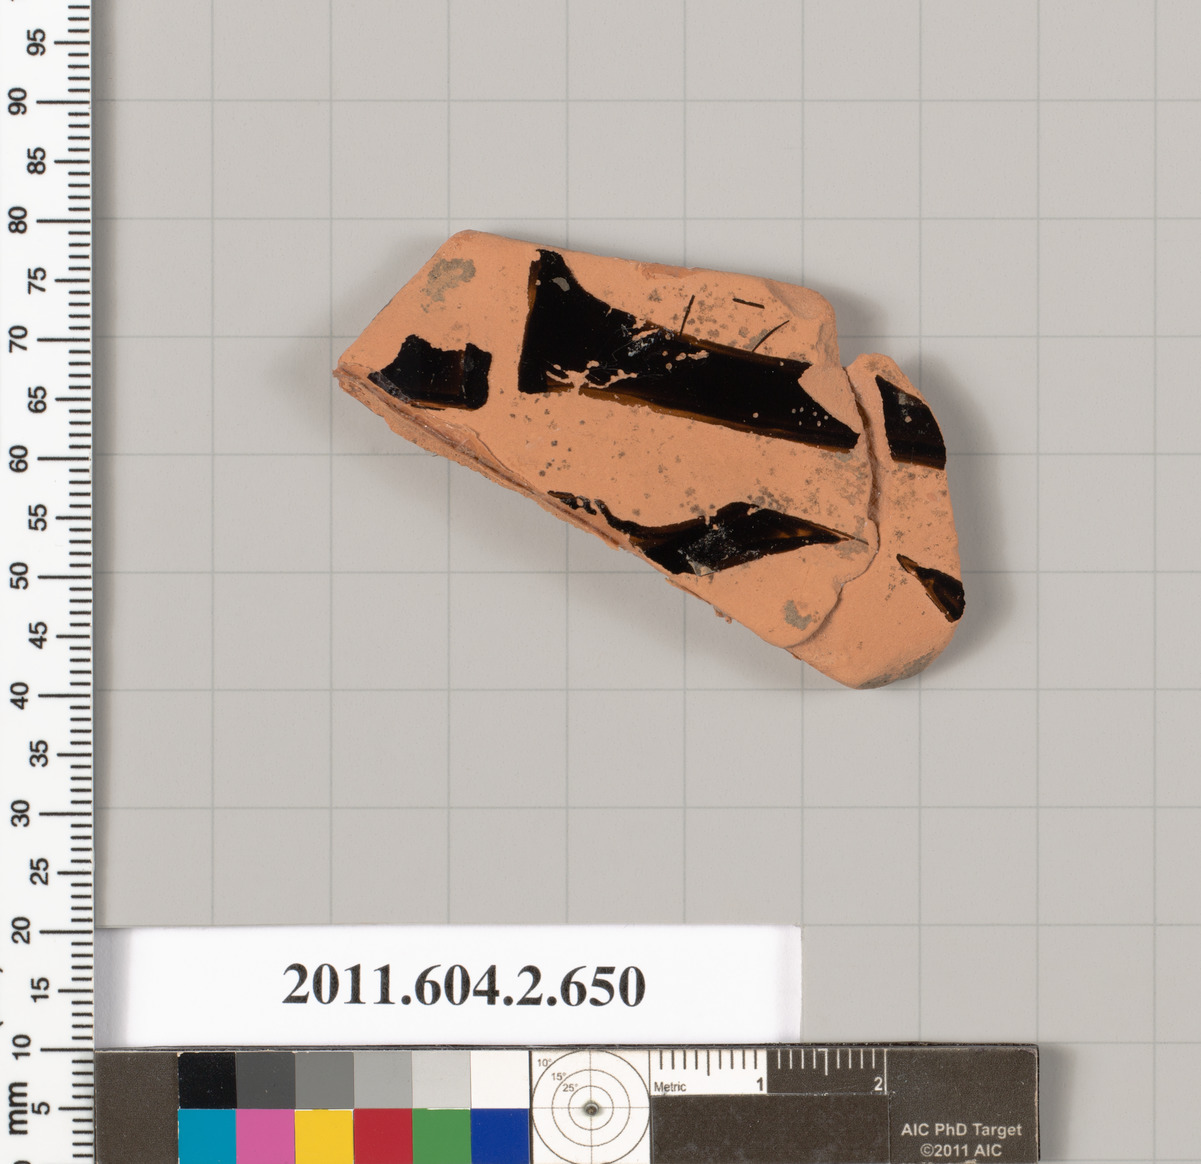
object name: column krater fragment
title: Terracotta fragment of a column-krater (bowl for mixing wine and water)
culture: greek, attic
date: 460-450 BCE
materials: terracotta